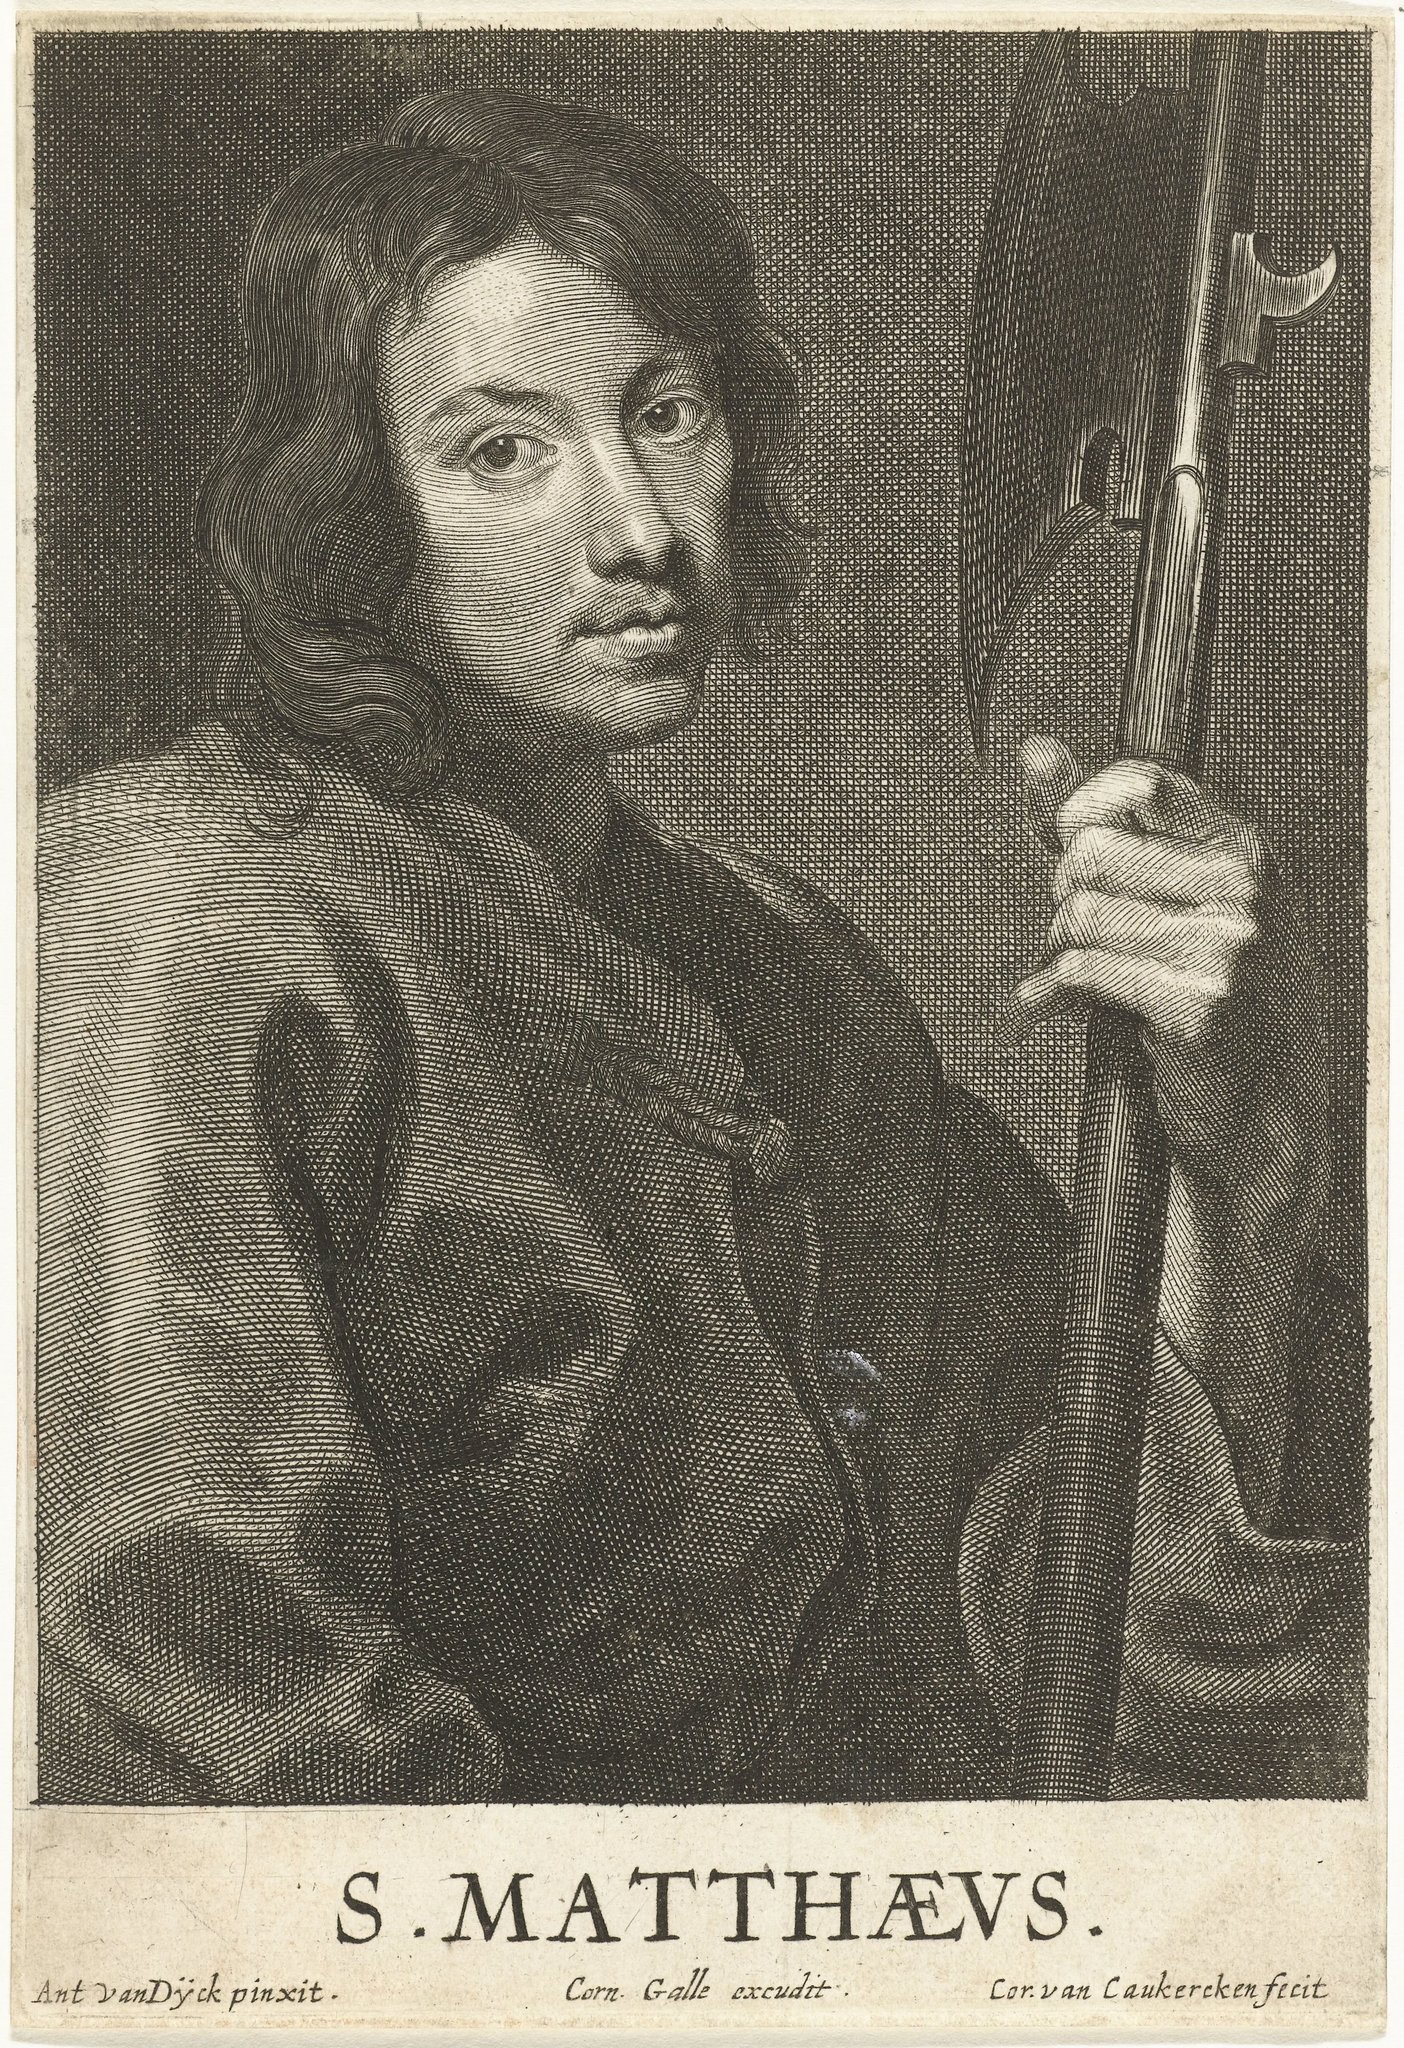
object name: print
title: Matteüs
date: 1640-1680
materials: paper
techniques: engraving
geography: antwerp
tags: the apostle and evangelist matthew (mattheus); possible attributes: angel, axe, book, halberd, pen and inkhorn, purse, scroll, square, sword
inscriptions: collector's mark: Lugt 2228